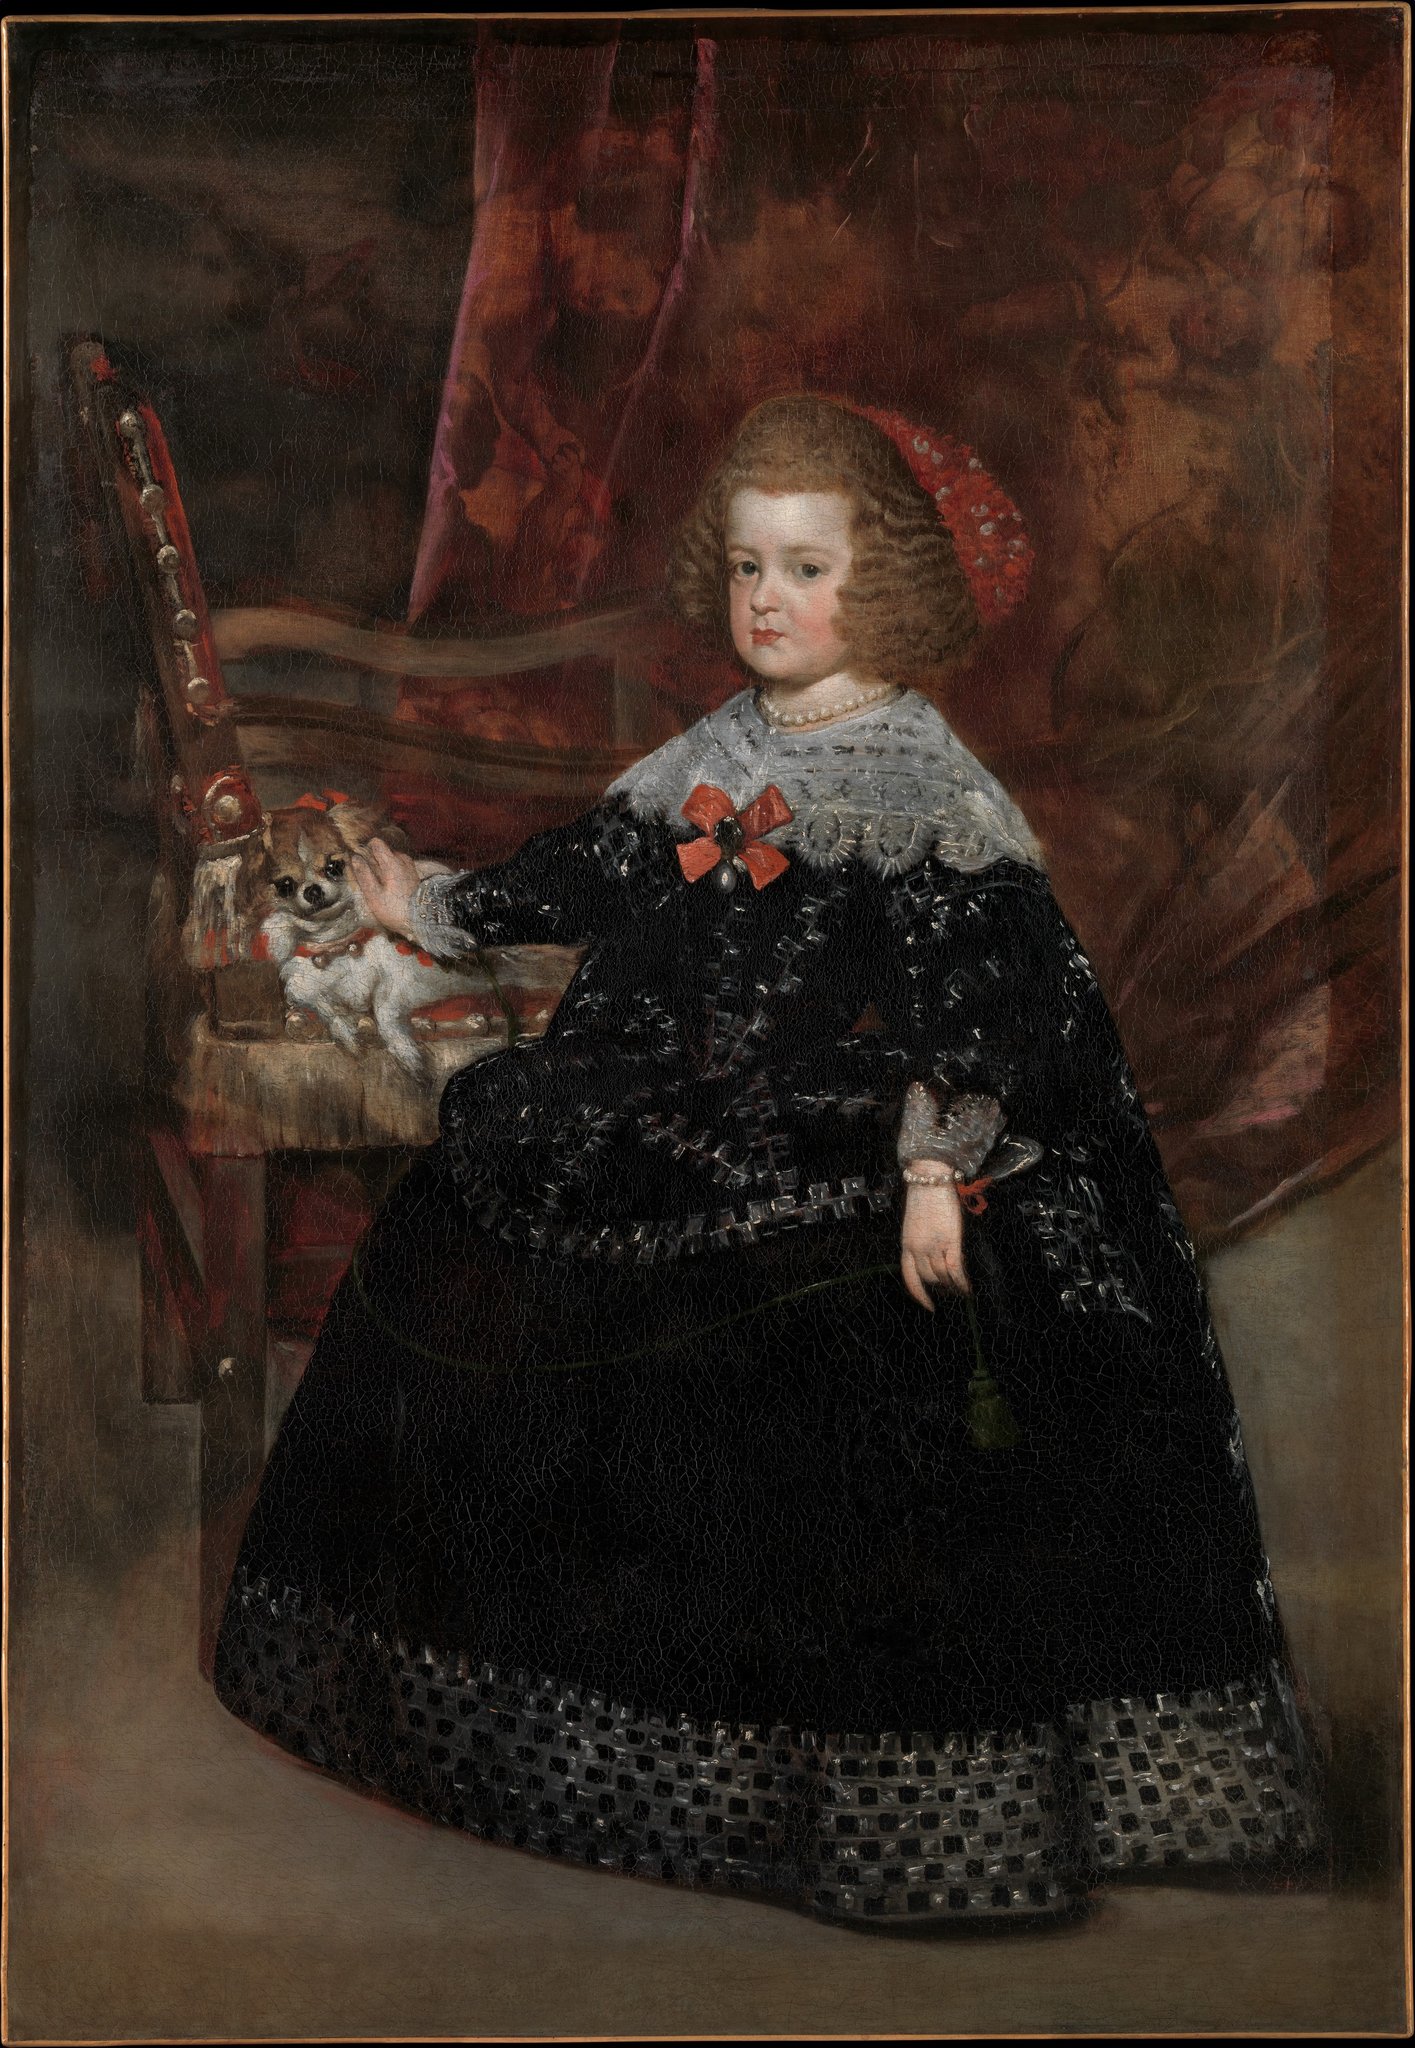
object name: painting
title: María Teresa (1638–1683), Infanta of Spain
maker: juan bautista martínez del mazo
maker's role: artist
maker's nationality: spanish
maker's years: 1612-1667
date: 1646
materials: canvas, oil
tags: girls,portraits,dogs